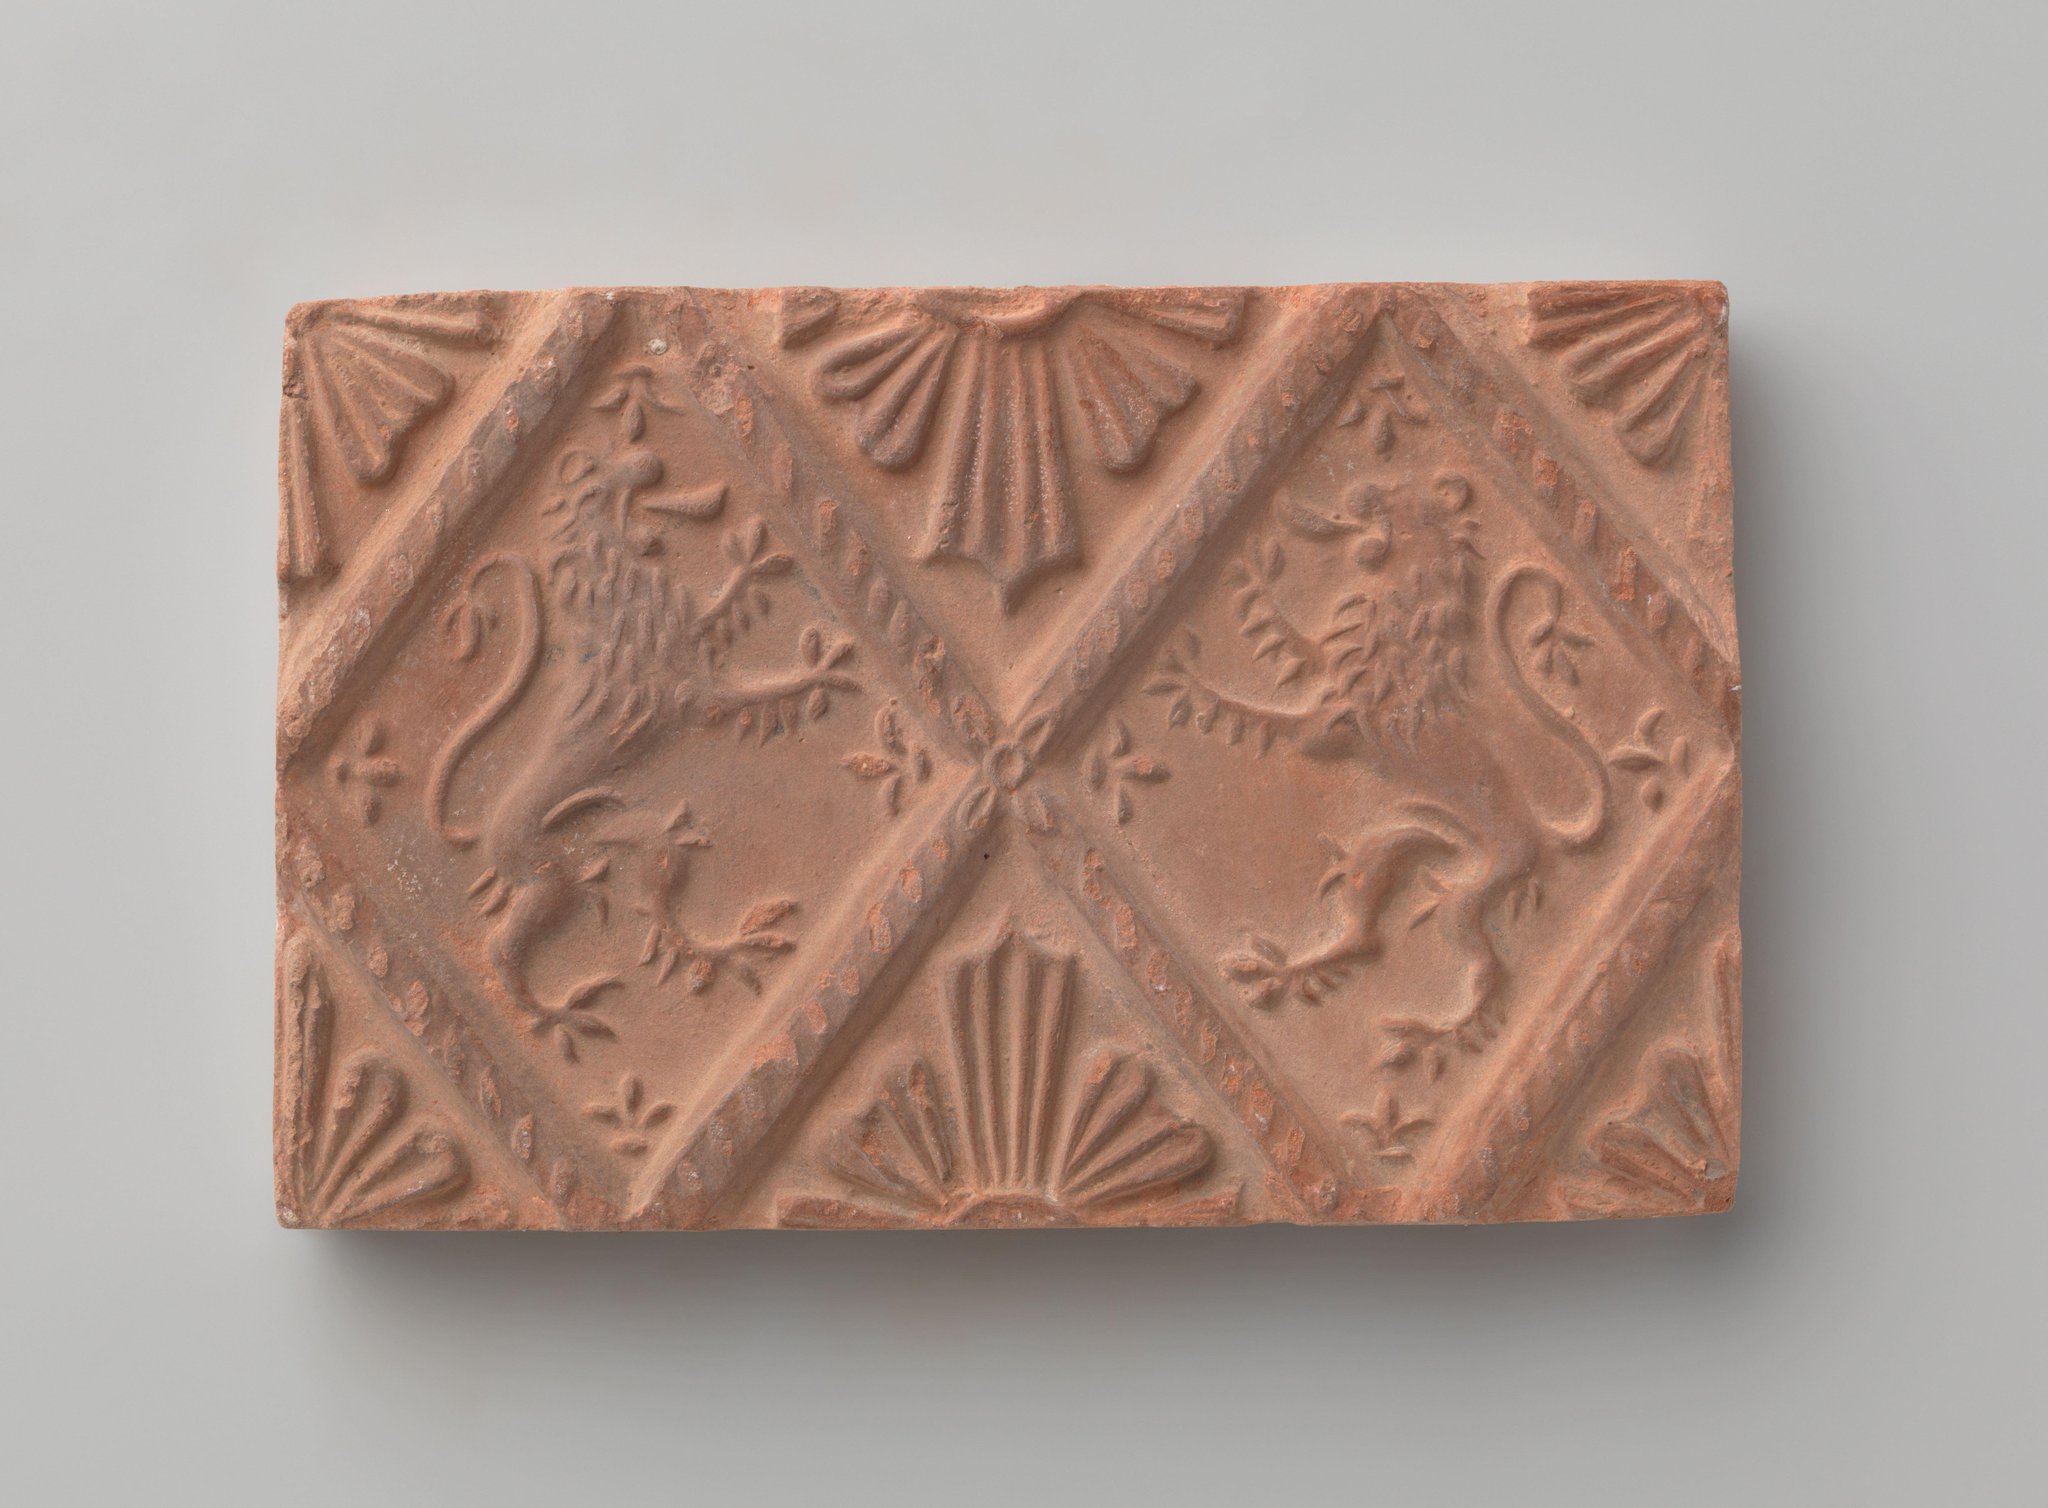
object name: hearthstone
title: Haardsteen met voorstelling van twee klimmende leeuwen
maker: Anonymous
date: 1875-1900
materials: earthenware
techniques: printing, firing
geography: netherlands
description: Haardsteen met voorstelling van twee klimmende leeuwen, geplaatst in geprofileerde ruit. De halve ruiten aan de boven- en onderkant zijn opgevuld met stermotief.